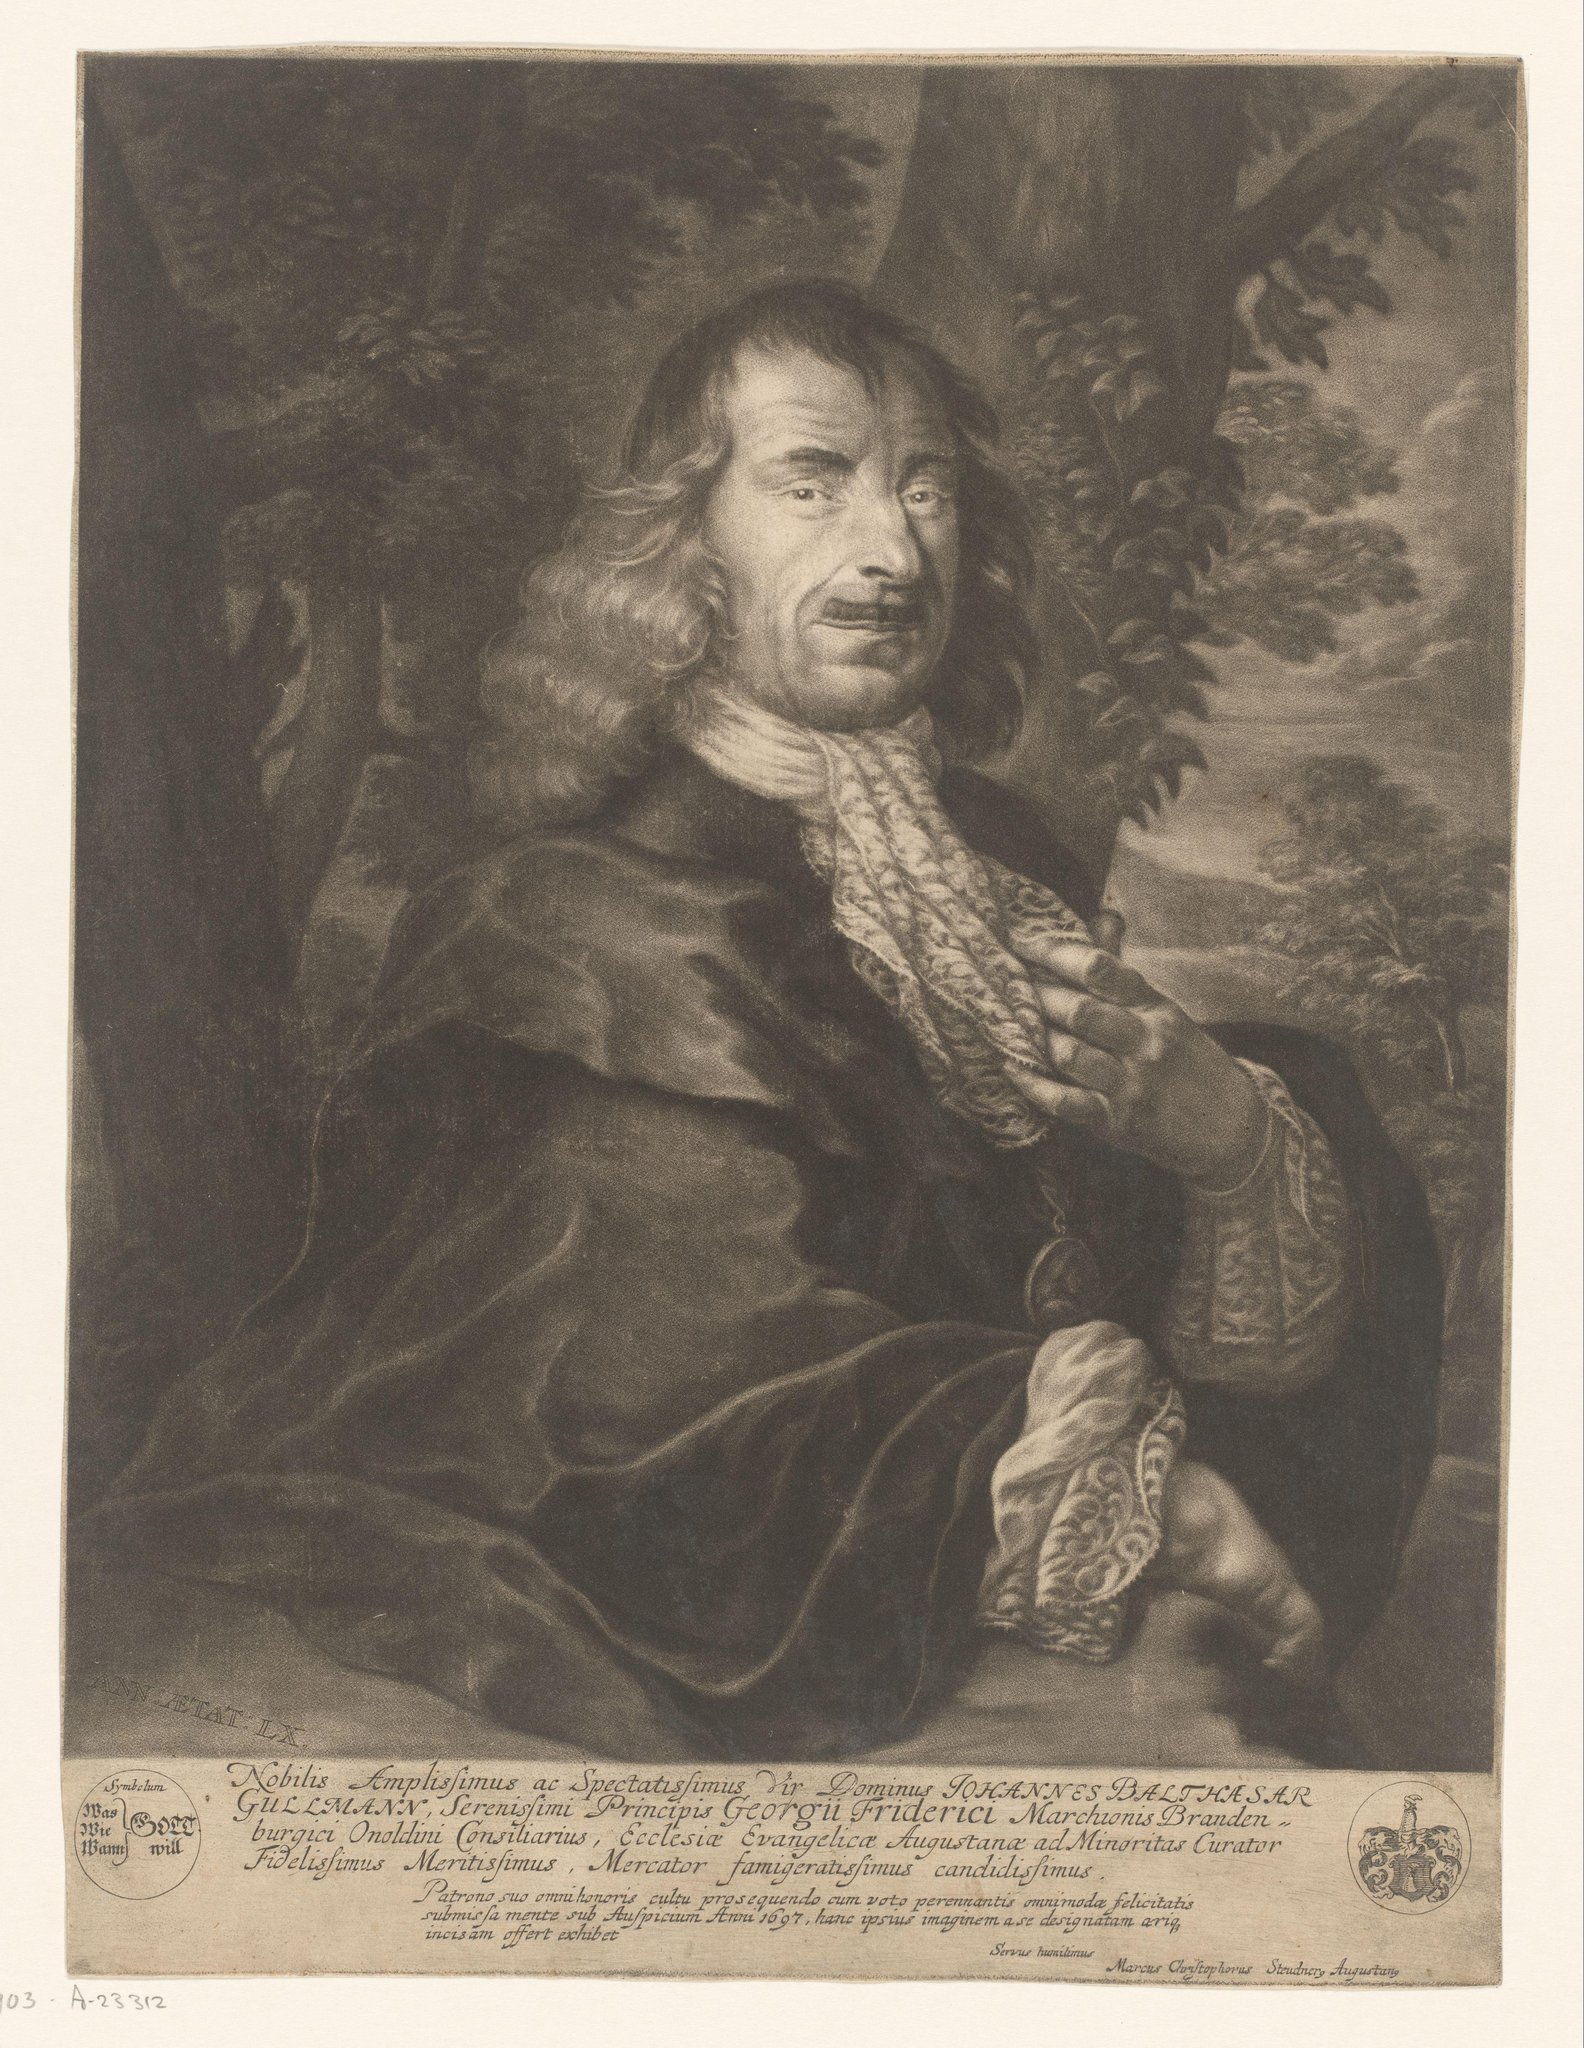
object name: print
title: Portret van Johann Balthasar Gullmann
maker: marc christoph steudner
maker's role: painter, print maker, sculptor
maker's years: 1660-1704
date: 1697-1704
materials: paper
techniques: mezzotint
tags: historical persons, armorial bearing, heraldry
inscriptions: collector's mark: Lugt 2228